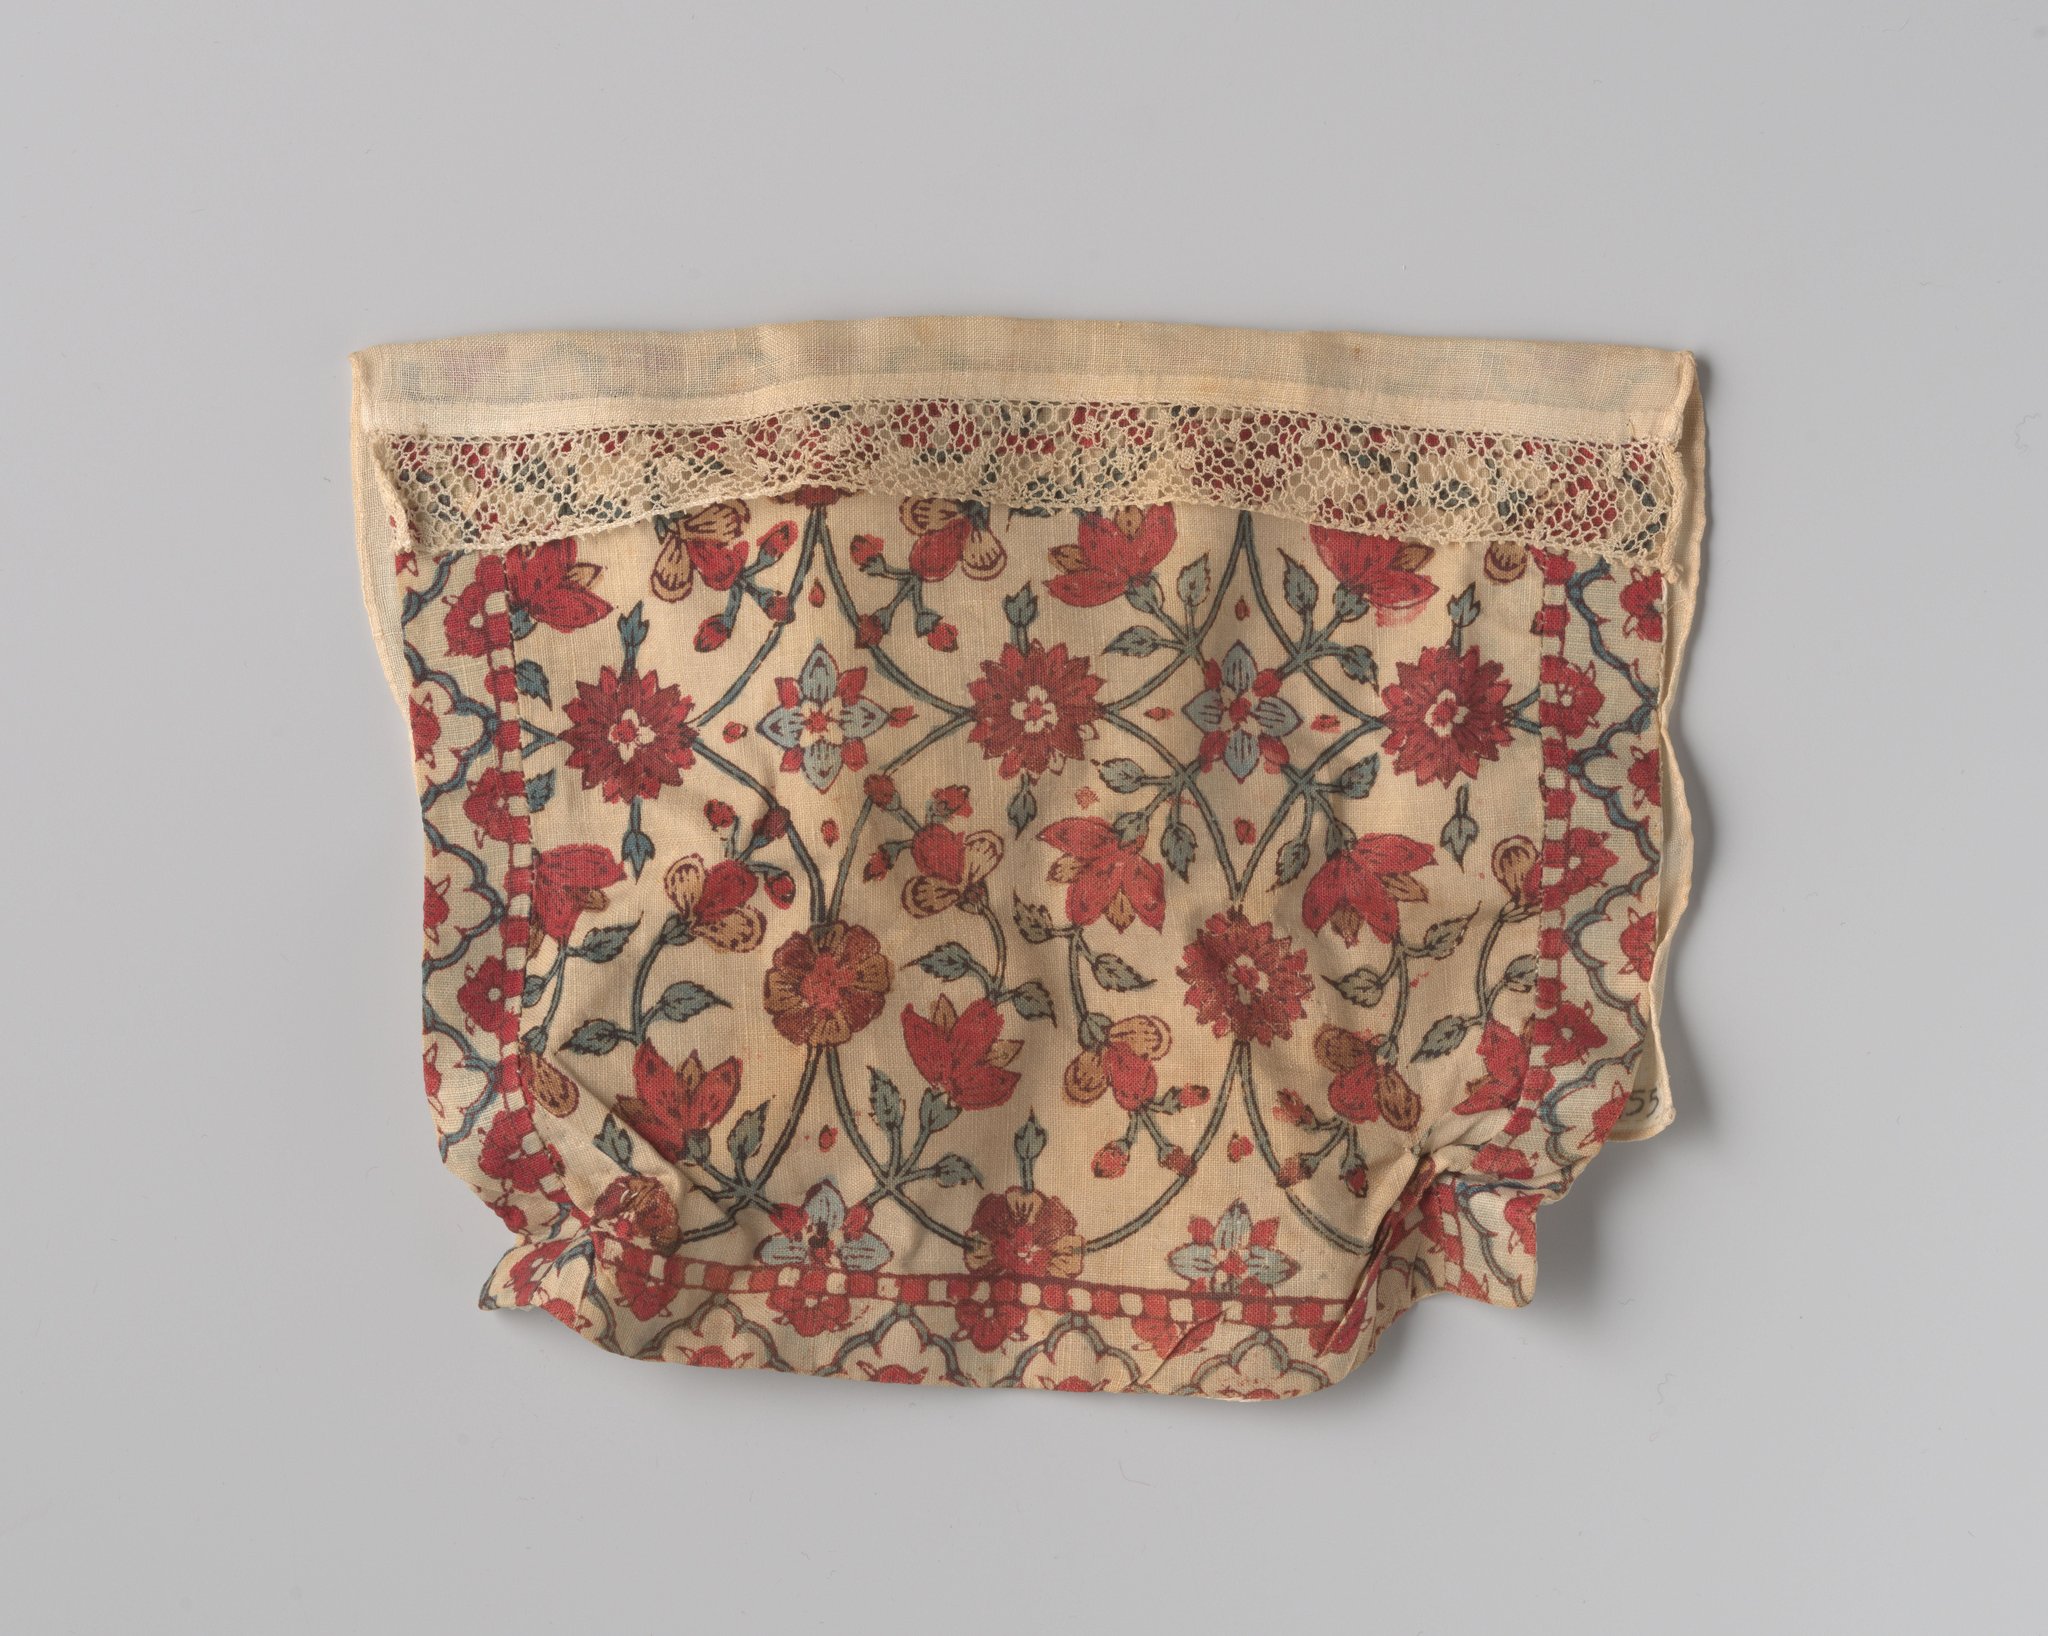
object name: bedspread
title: Sprei voor wieg, van beschilderde katoen (sits), gevoerd met crème kleurige zijde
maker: Anonymous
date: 1690-1710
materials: cotton, silk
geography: india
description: Sprei voor de wieg, van bischilderde katoen (sits), gevoerd met crème kleurige zijde, zonder tussenlaag; dessin een gestileerd bloemmotief met banden in lichtblauw, rood, donkerrood en lichtbruin, rondom afgezet met rand (één zijde vast, drie zijden aangenaaid).